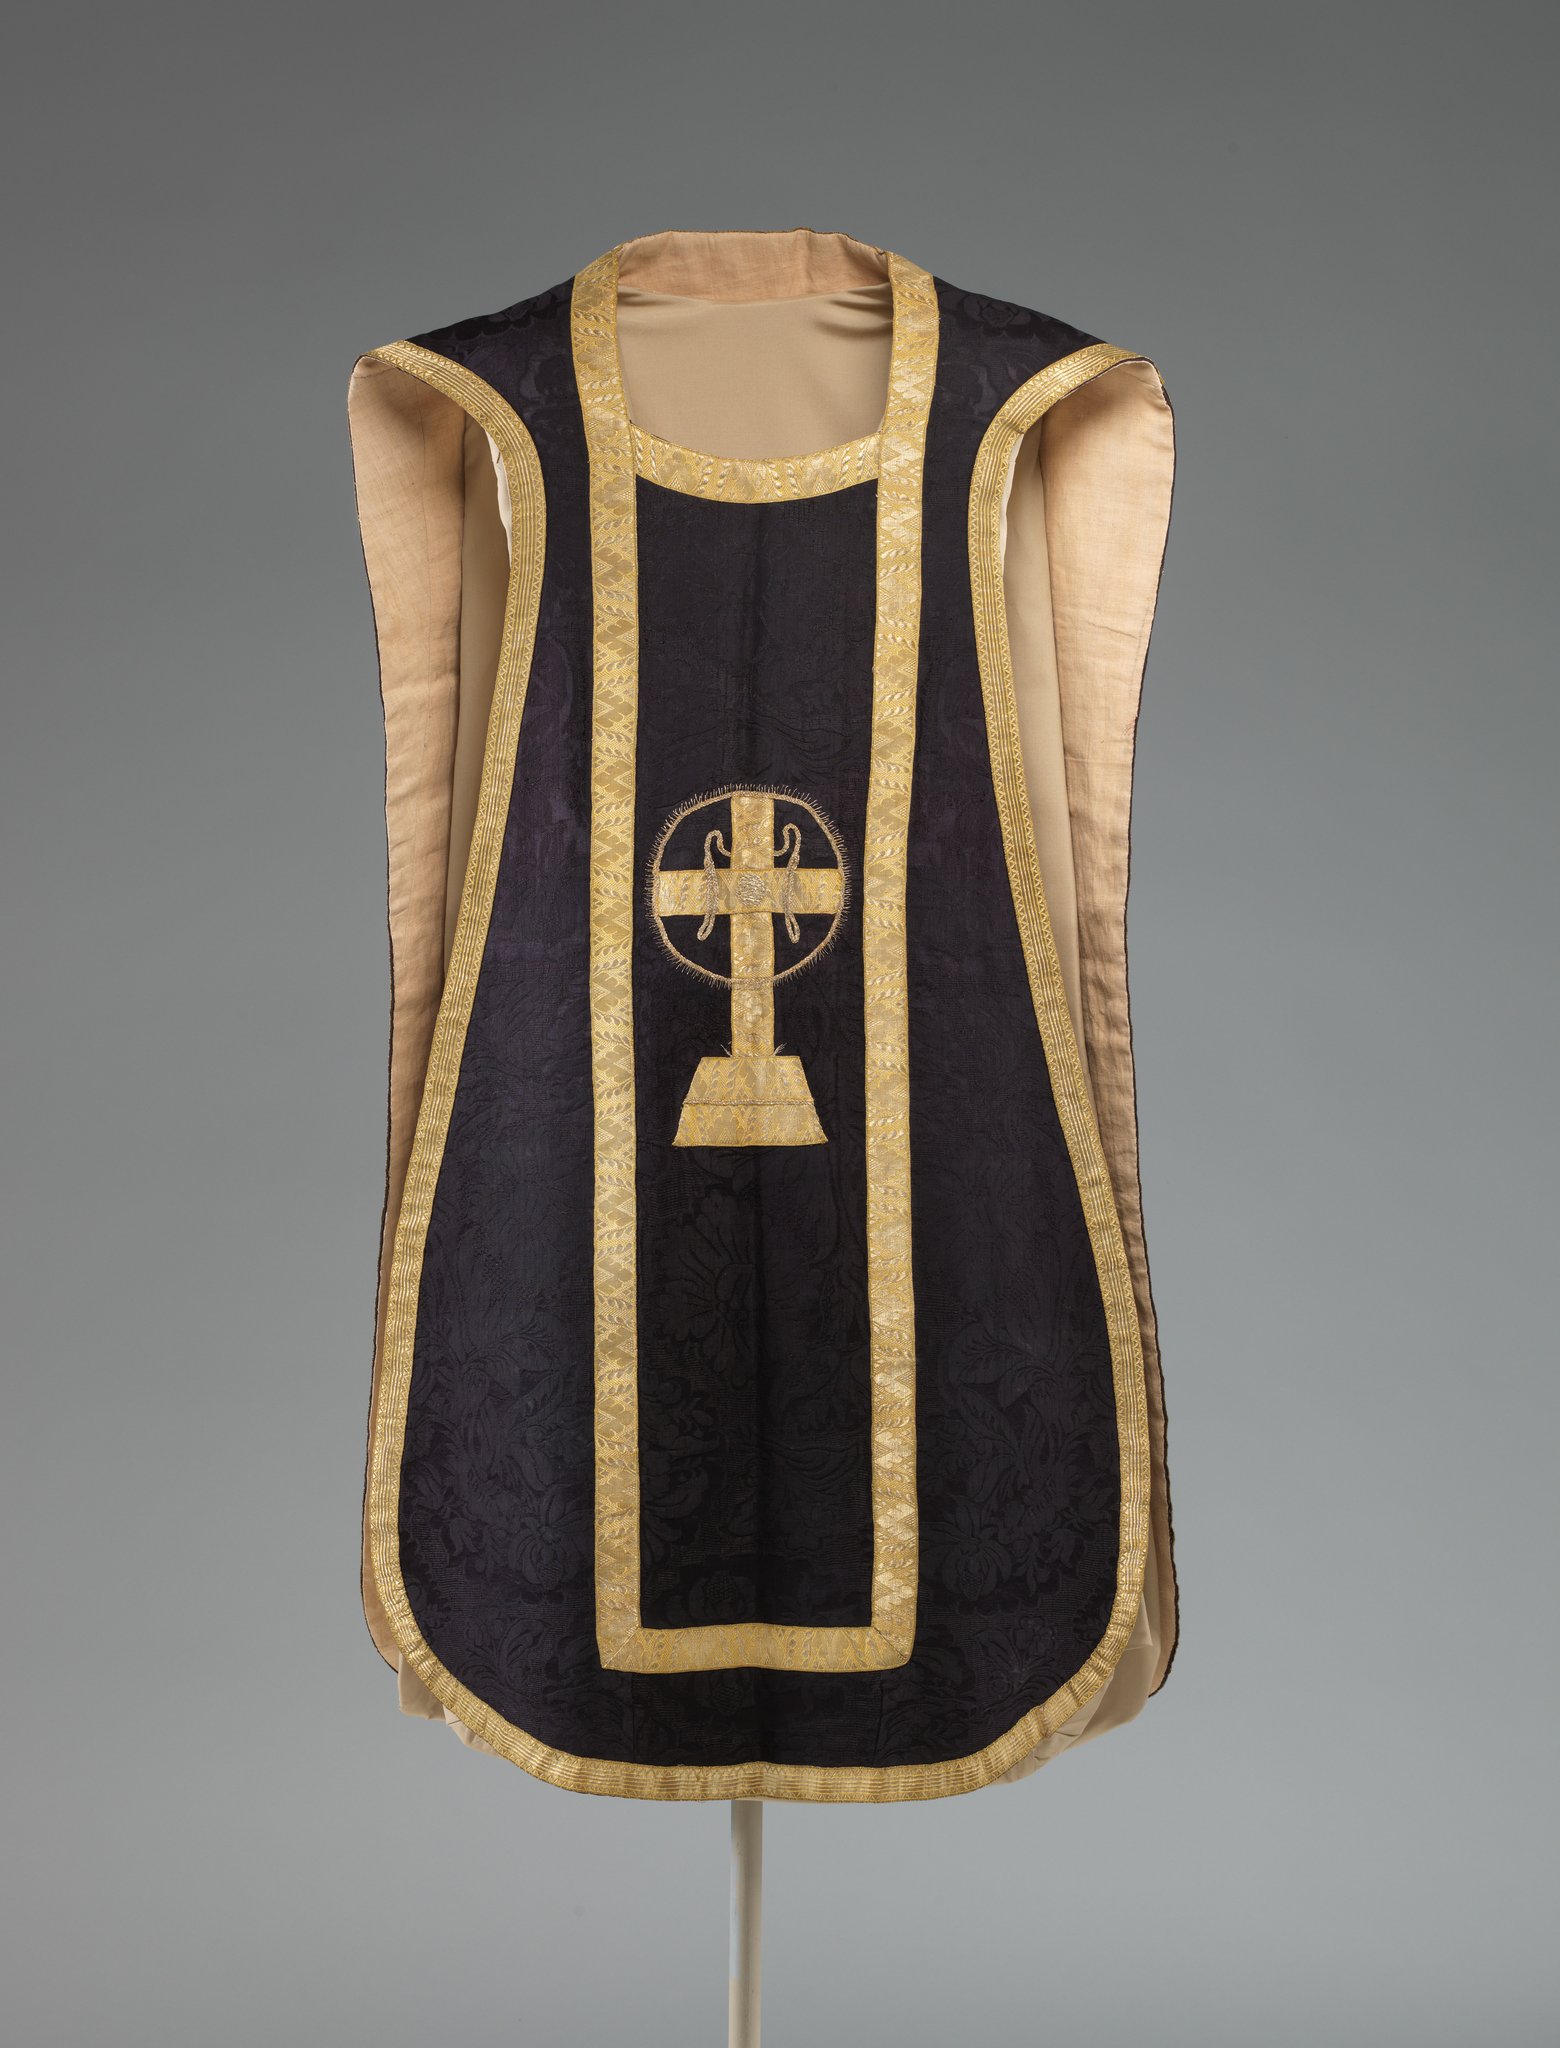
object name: chasuble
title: Funerary chasuble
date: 1767-1833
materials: metal thread, ribbon, silk, velvet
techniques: damask, embroidery, weave